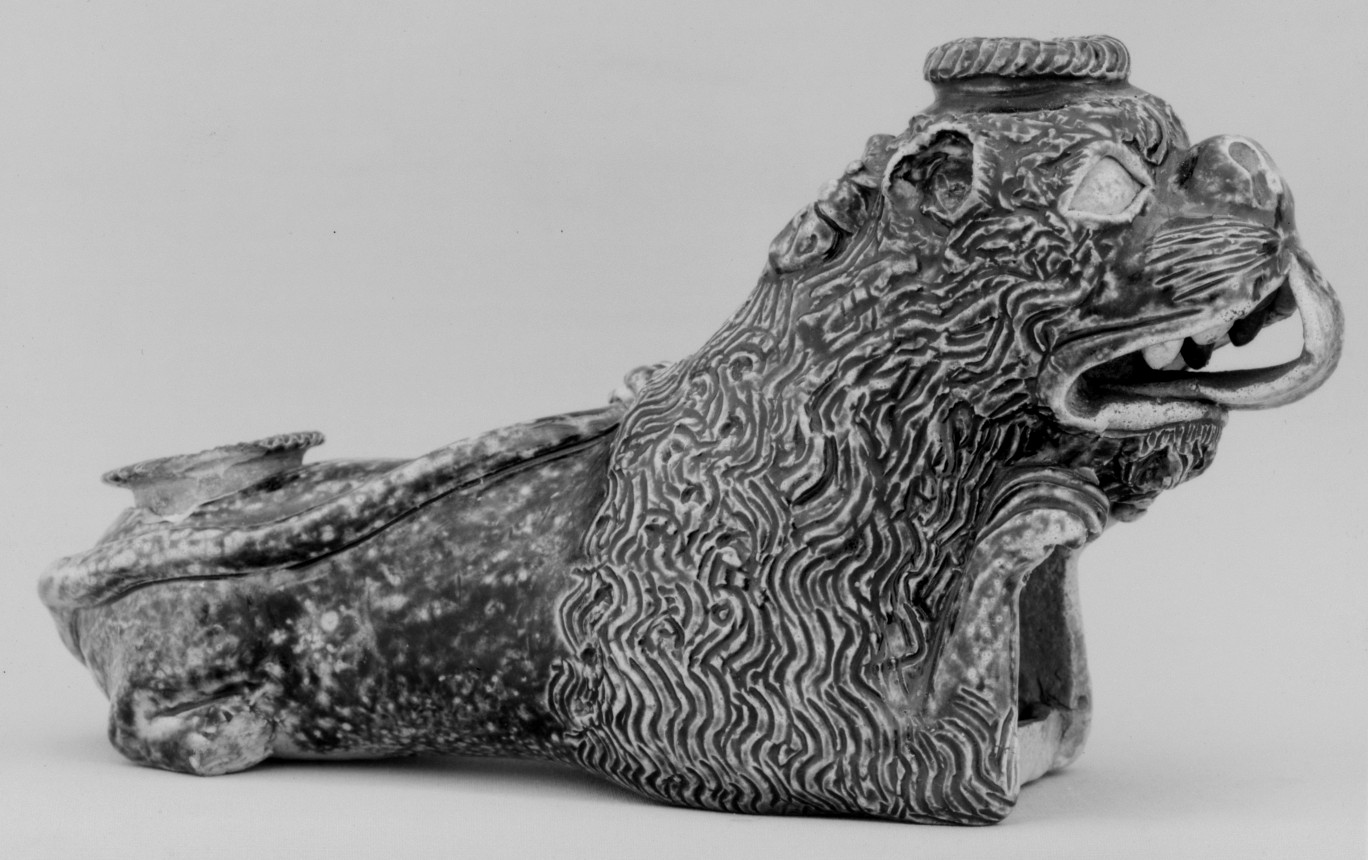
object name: inkstand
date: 1701-1800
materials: stoneware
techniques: salt glaze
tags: lions